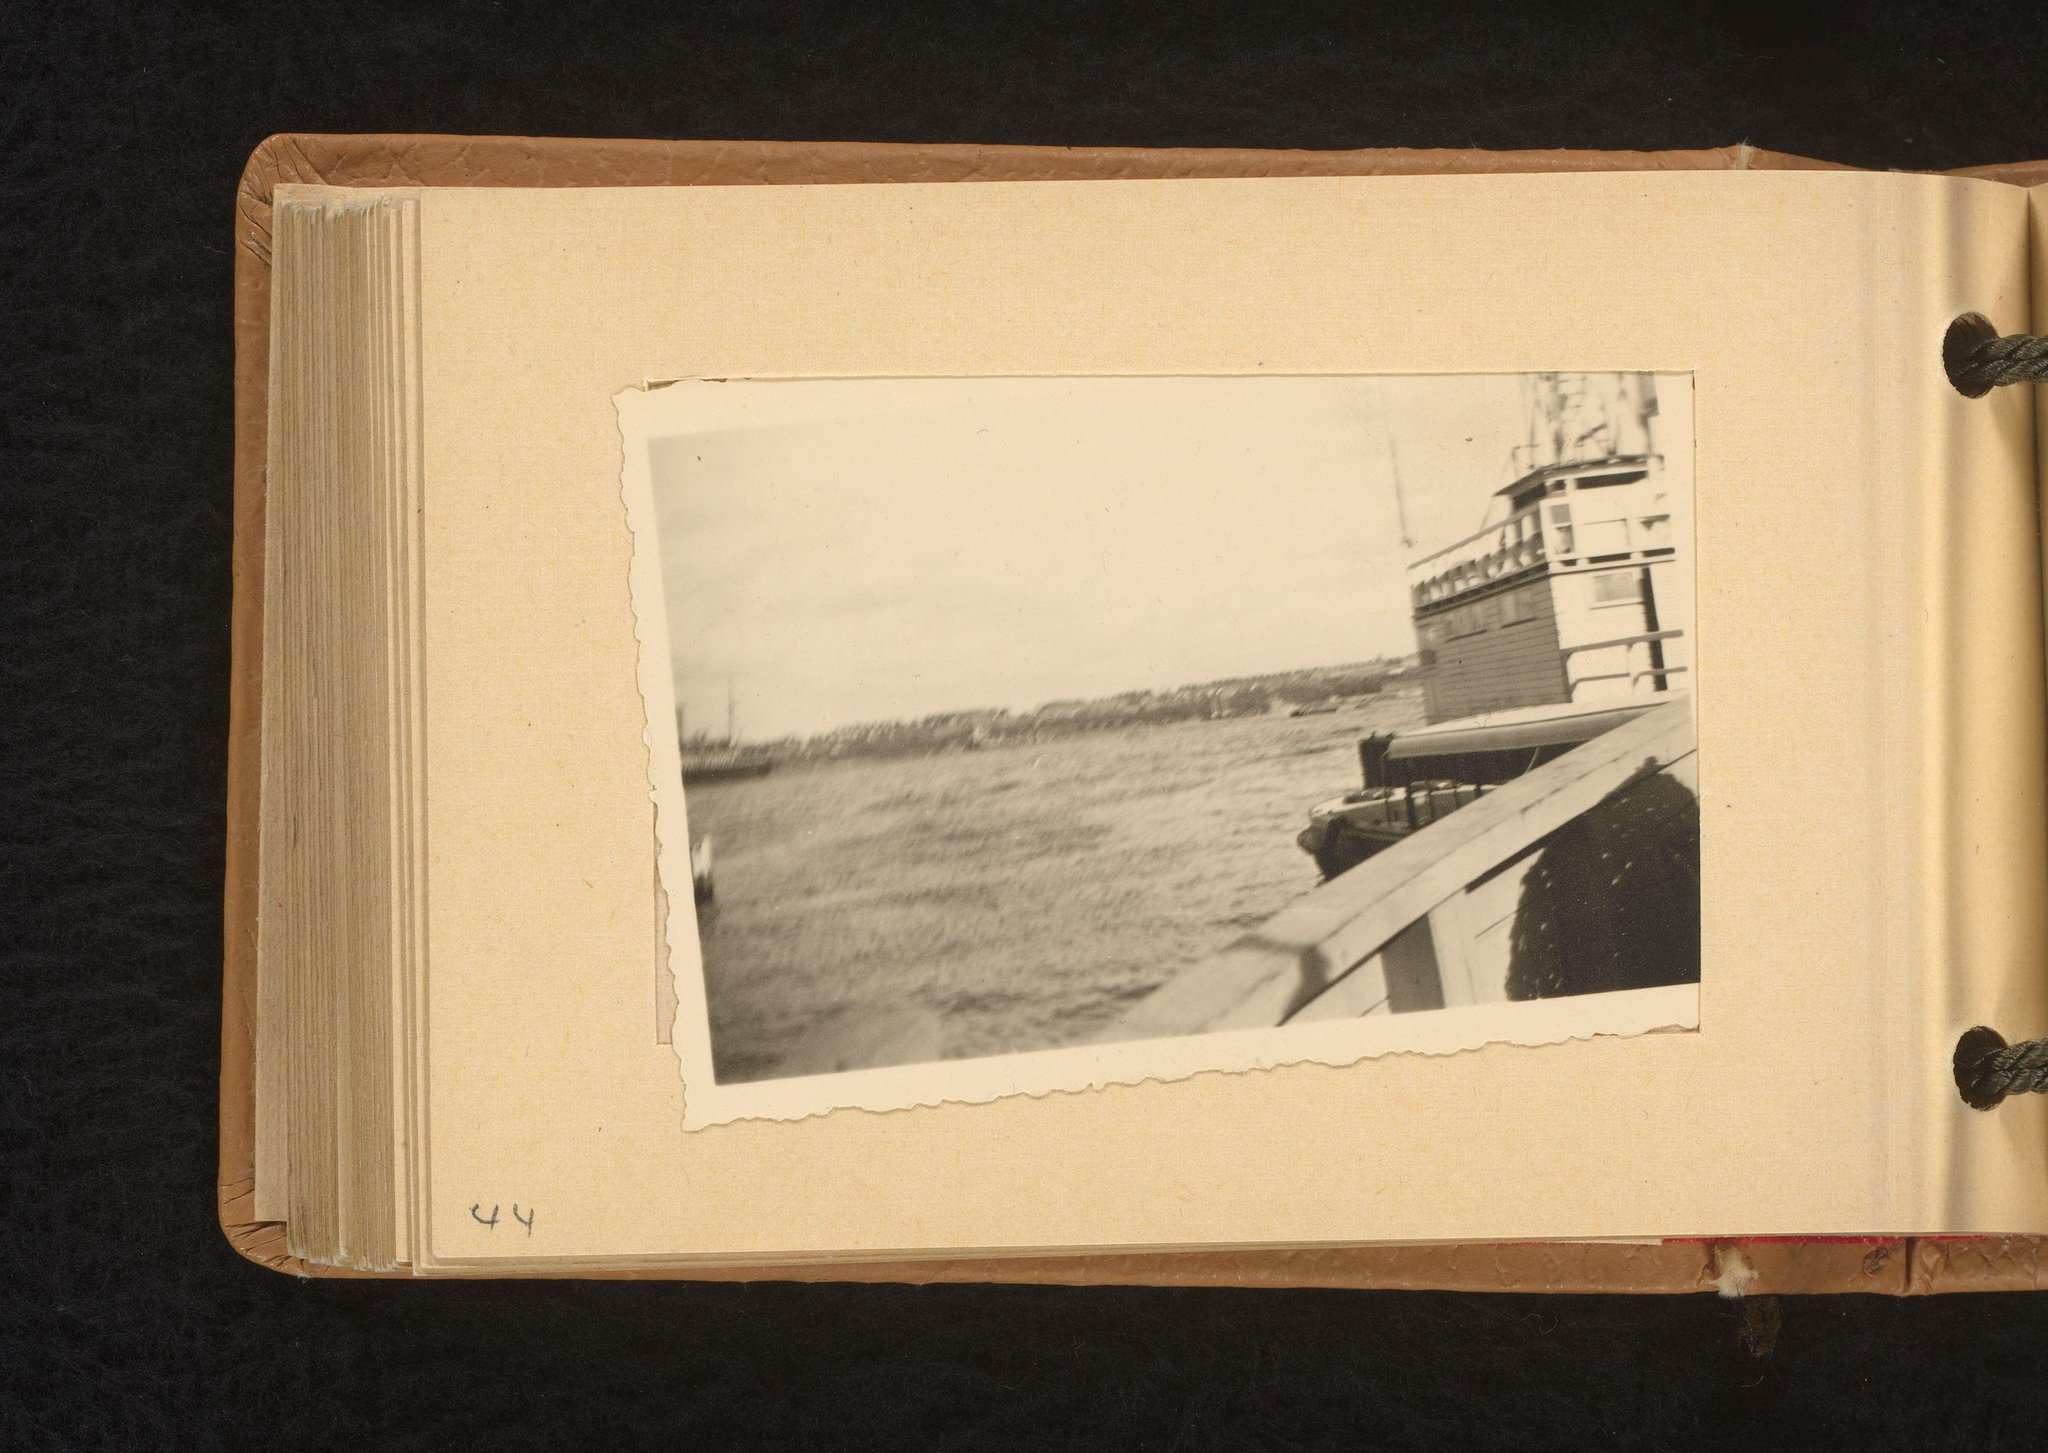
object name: album leaf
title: Vanaf de railing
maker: Anonymous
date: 1940-1943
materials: paper, photographic support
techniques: gelatin silver print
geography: netherlands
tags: occupation ~ war, netherlands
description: Albumblad met een foto vanaf de railing van een schip of de kade van water en land. Onderdeel van een klein album van de Kriegsmarine in Nederland.